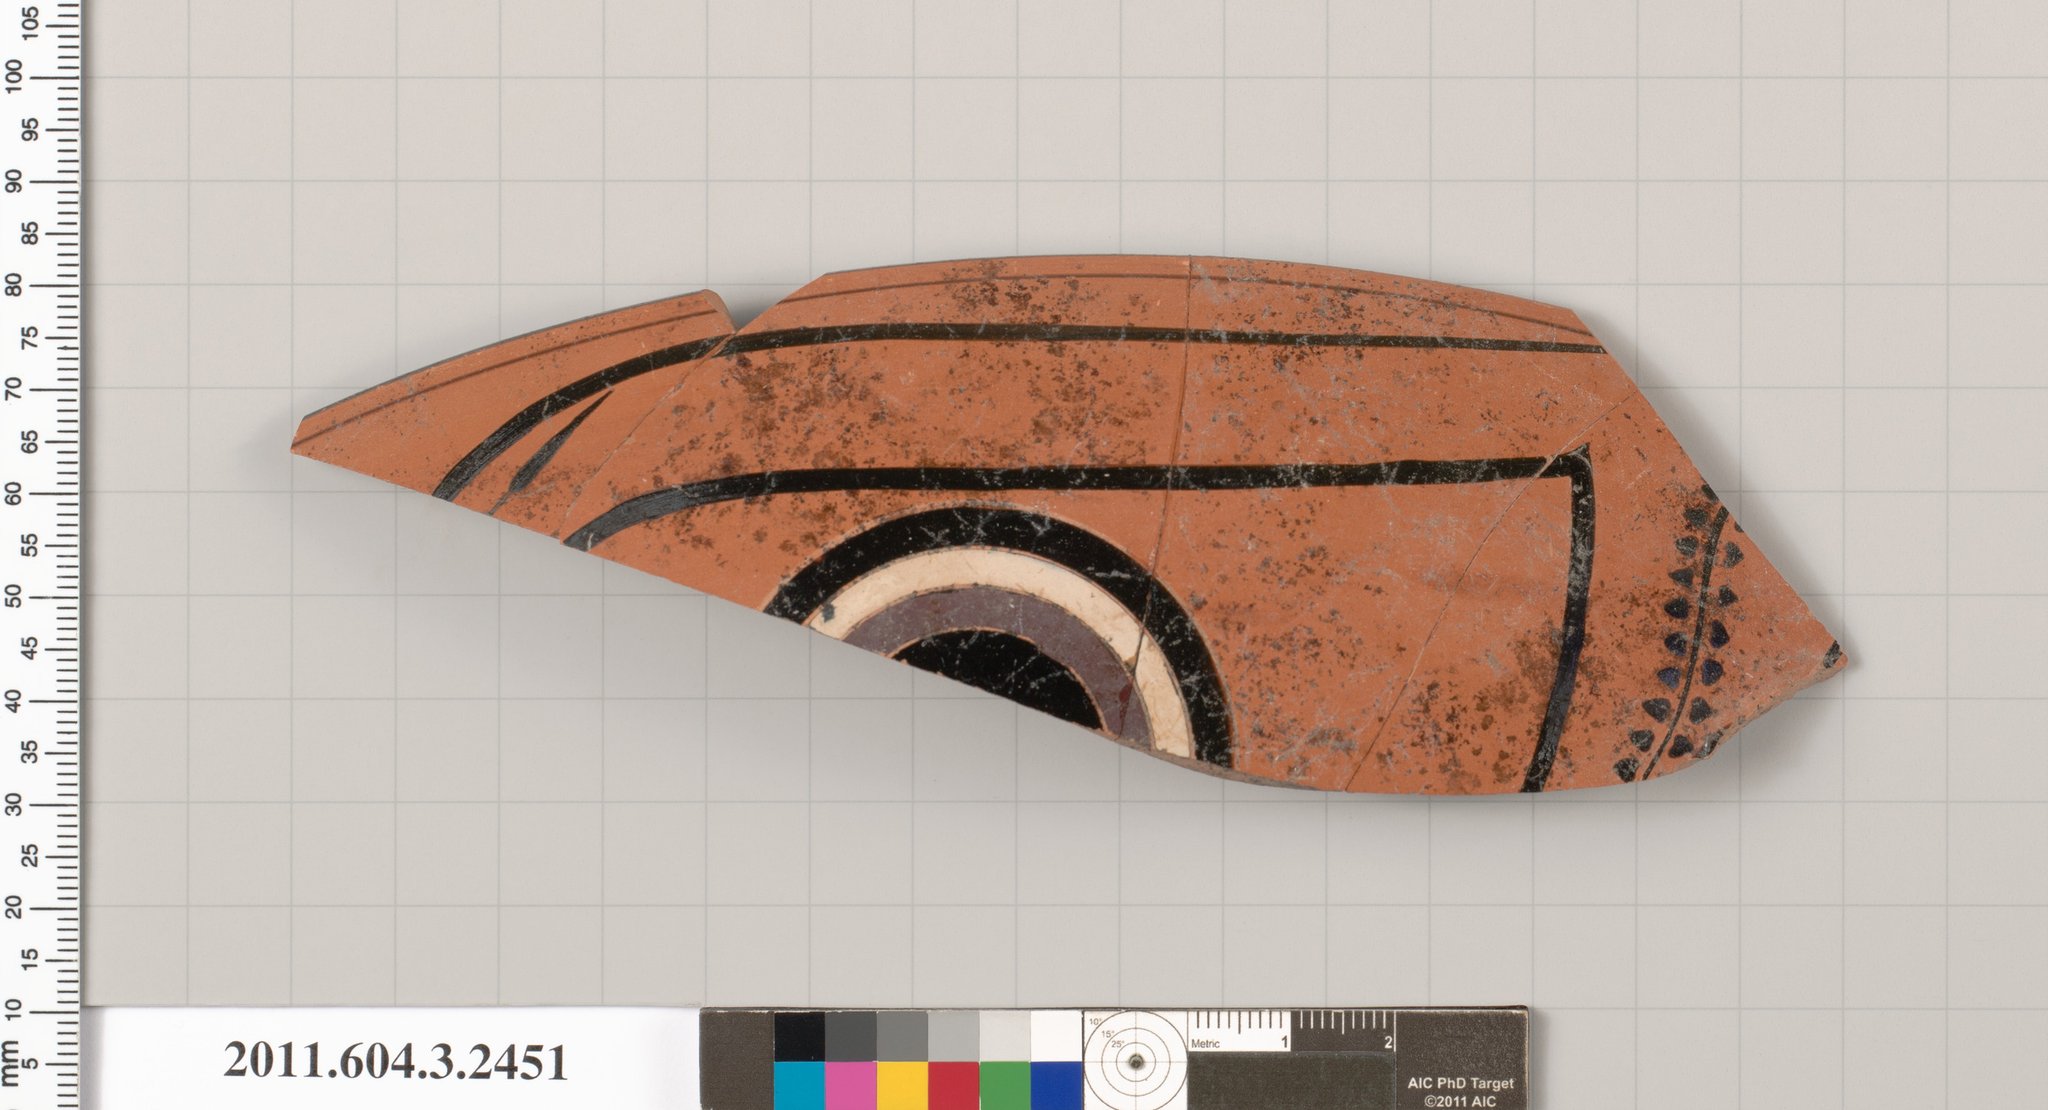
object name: kylix fragment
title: Terracotta rim fragment of a kylix: eye-cup (drinking cup)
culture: greek, attic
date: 530-520 BCE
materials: terracotta